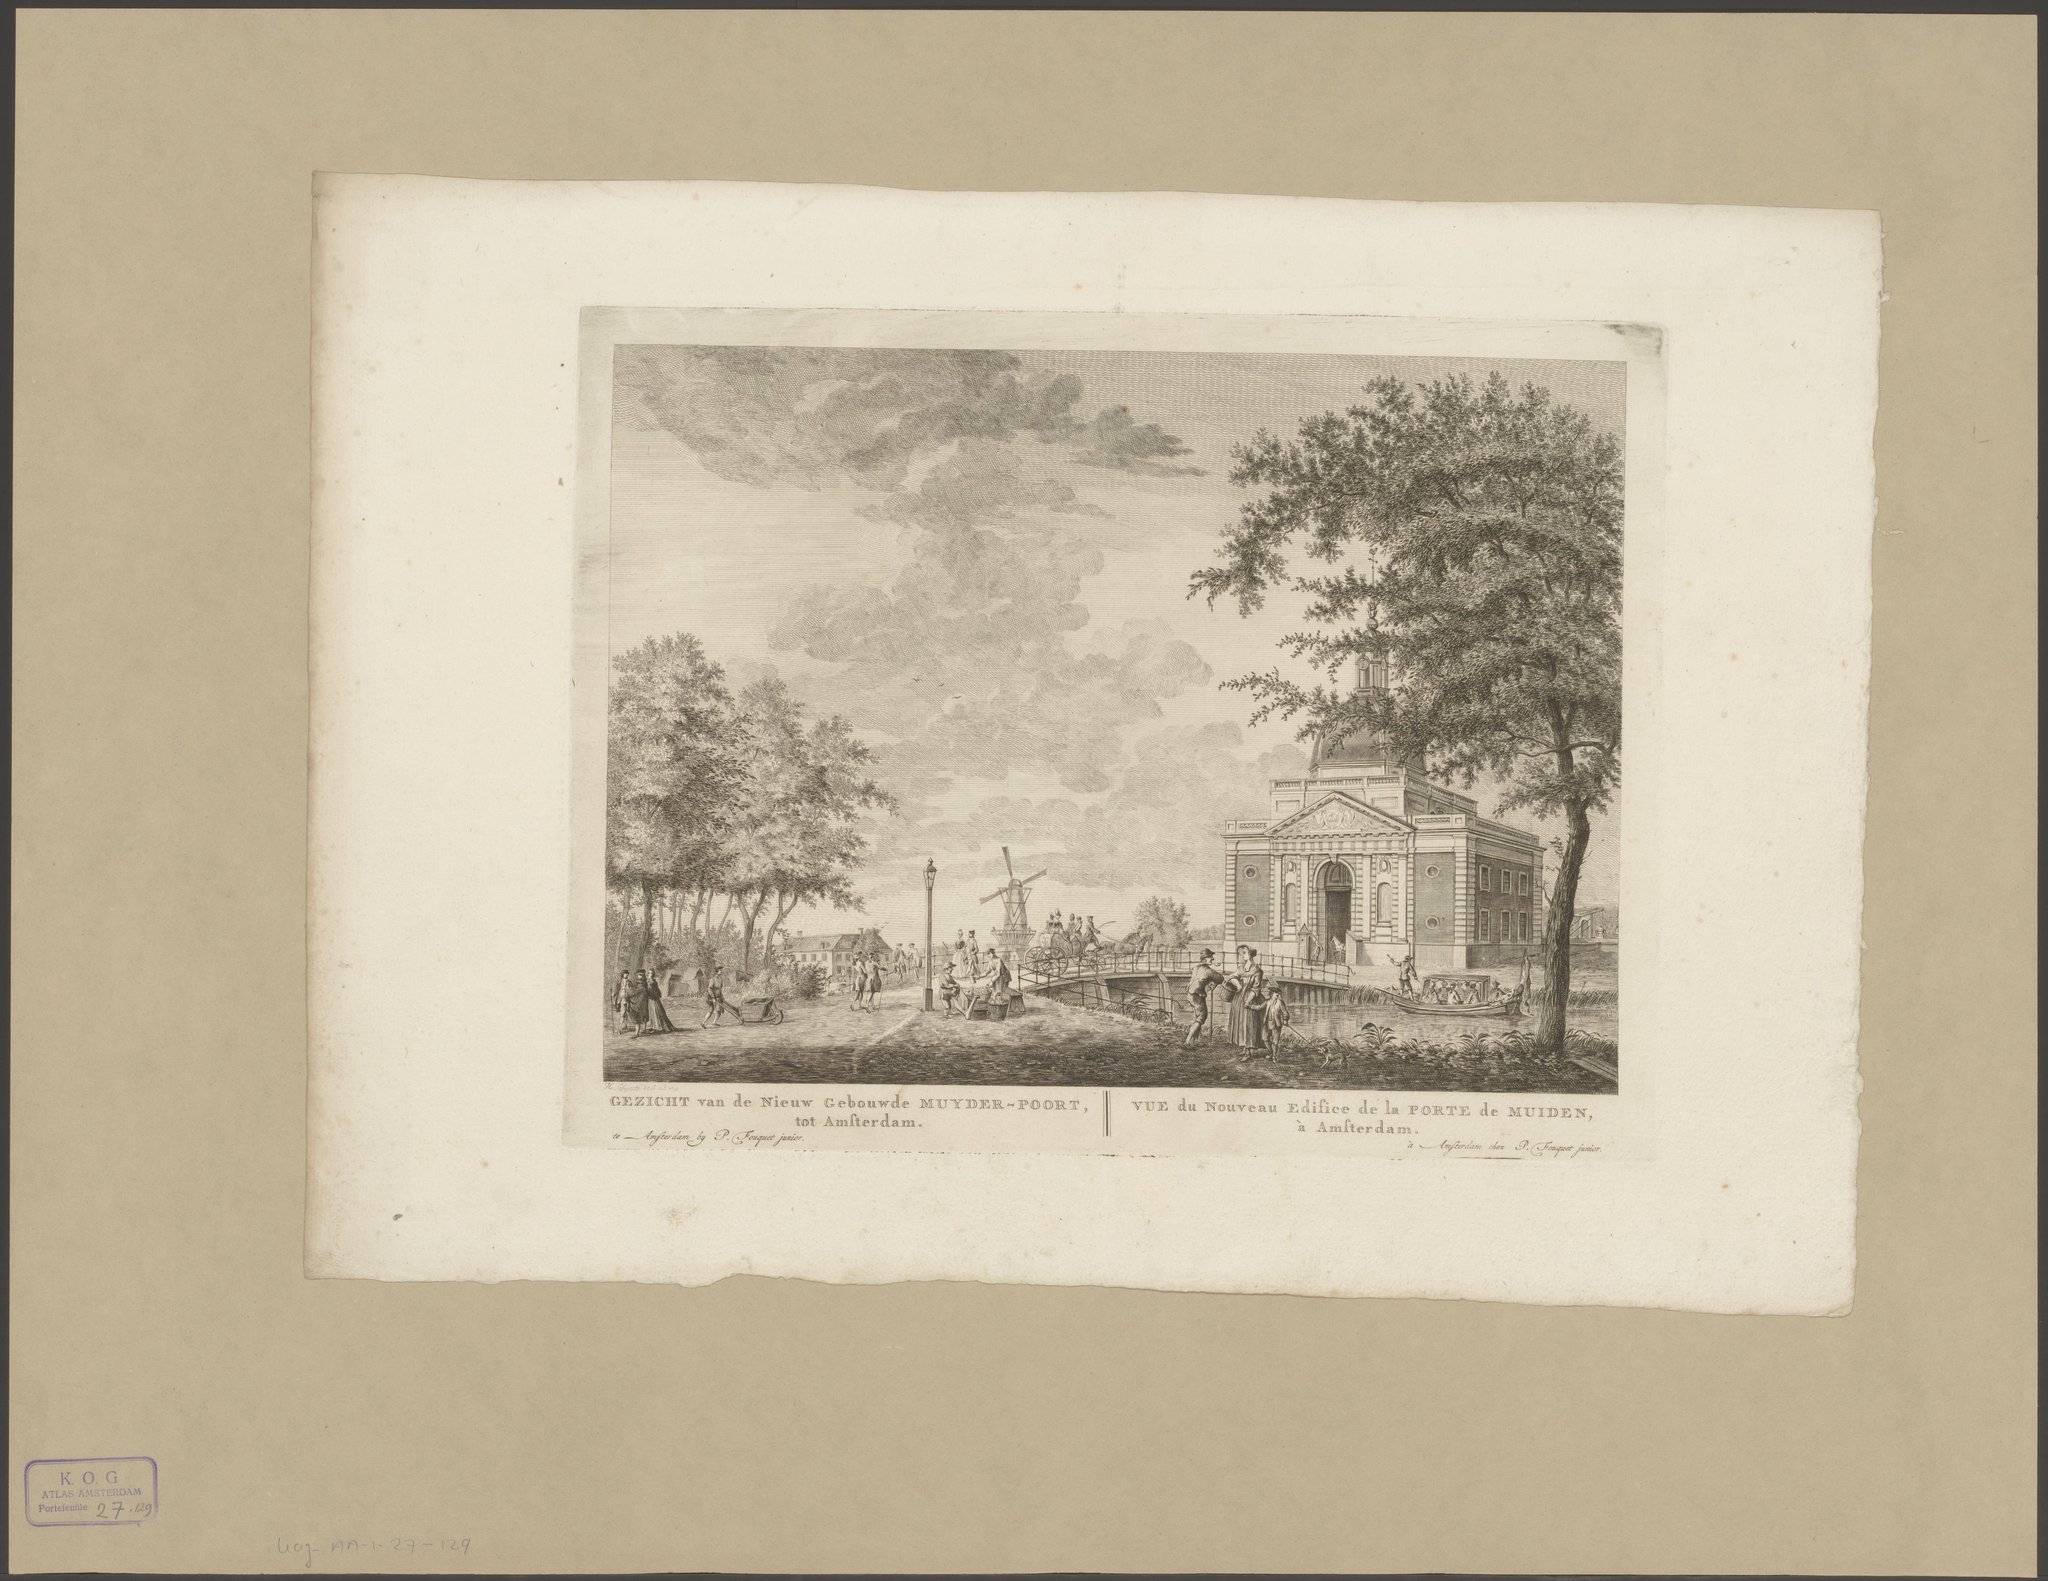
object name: print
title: Gezicht op de Tweede Muiderpoort te Amsterdam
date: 1771-1783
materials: paper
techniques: engraving, etching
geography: amsterdam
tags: bridge in city across river, canal, etc. (+ city(-scape) with figures, staffage), canals, waters (in city), windmill, city-gate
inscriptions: collector's mark: Lugt 1641b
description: Latere staten van deze prent zijn ook gebruikt in de zogenaamde Atlas van Fouquet.* Pierre Fouquet gaf vanaf 1760 stadsgezichten van Amsterdam - naar tekeningen van verschillende kunstenaars, gemaakt door verschillende prentmakers - uit. Deze prenten werden aanvankelijk los of in series verkocht. Zoals toen gebruikelijk kon de koper de prenten zelf laten inbinden. Hiertoe gaf Fouquet tussen 1778 en 1783 een titelblad, plattegrond en inhoudsopgave van de tot dusver 100 uitgegeven prenten uit (1). Gezien de inhoud afhankelijk was van wat de koper had verzameld verschilt de inhoud van de verschillende bewaarde Fouquetatlassen onder deze titel sterk. Ook zijn er exemplaren bekend waar tevens andere prenten aan zijn toegevoegd. Omdat er behoefte bleek aan uitleg bij de platen werd in 1783 een nieuwe versie van de atlas uitgegeven, aangevuld met tekst en twee prenten. De aangegeven volgorde veranderde maar de platen van de al eerder uitgegeven prenten bleven ongewijzigd. Deze uitgave werd in opdracht van Fouquet gedrukt bij Daniël Jean Changuion en Petrus den Hengst (2). Een tiental platen werd bijgewerkt en verscheen, met nieuw impressum, in het vervolg van Wagenaars geschiedenis van Amsterdam, uitgeven door Petrus Conradi en Folkert van der Plaats (3). Een aantal jaar na het overlijden van Fouquet kwam Evert Maaskamp met een nieuwe uitgave van de atlas, met verbeterde tekst en toevoeging van twee prenten. Op alle platen verwijderde hij het oude en liet hij zijn eigen impressum zetten (4). * Onder de Atlas van Fouquet of Fouquetatlas verstaan we de hieronder vermelde publicaties (1), (2) en (4). (1). Afbeeldingen van de wyd-vermaarde koopstad Amsterdam benevens des zelvs voornaamste gebouwen en gezigten alle naar het leeven getekend / Receuil des edifices les plus considerables et des plus belles vues, de la fameuse ville d'Amsterdam, dessinées d'après nature. Amsterdam: Pierre Fouquet, 1778-1783. (2). Nieuwe atlas, van de voornaamste gebouwen en gezigten der stad Amsterdam, met derzelver beknopte beschryvingen. 2 dln. Amsterdam: Daniël Jean Changuion en Petrus den Hengst [in opdracht van Pierre Fouquet], 1783. (3). Stijl, Simon. Amsterdam, in zyne geschiedenissen, voorregten, koophandel, gebouwen, kerkenstaat, schoolen, schutterye, gilden en regeeringe, beschreeven. Om te dienen ten vervolge op het werk van Jan Wagenaar (…). 10 dln. Amsterdam en Harlingen: Petrus Conradi en Folkert van der Plaats, 1788-1801. (4). Nieuwe atlas, van de voornaamste gebouwen en gezigten der stad Amsterdam. Met derzelver beknopte beschryvingen. Amsterdam: Evert Maaskamp, 1805. * Het aantal vermelde staten is gebaseerd op het aantal gevonden staten. Mogelijk zijn er meer staten van deze prent.